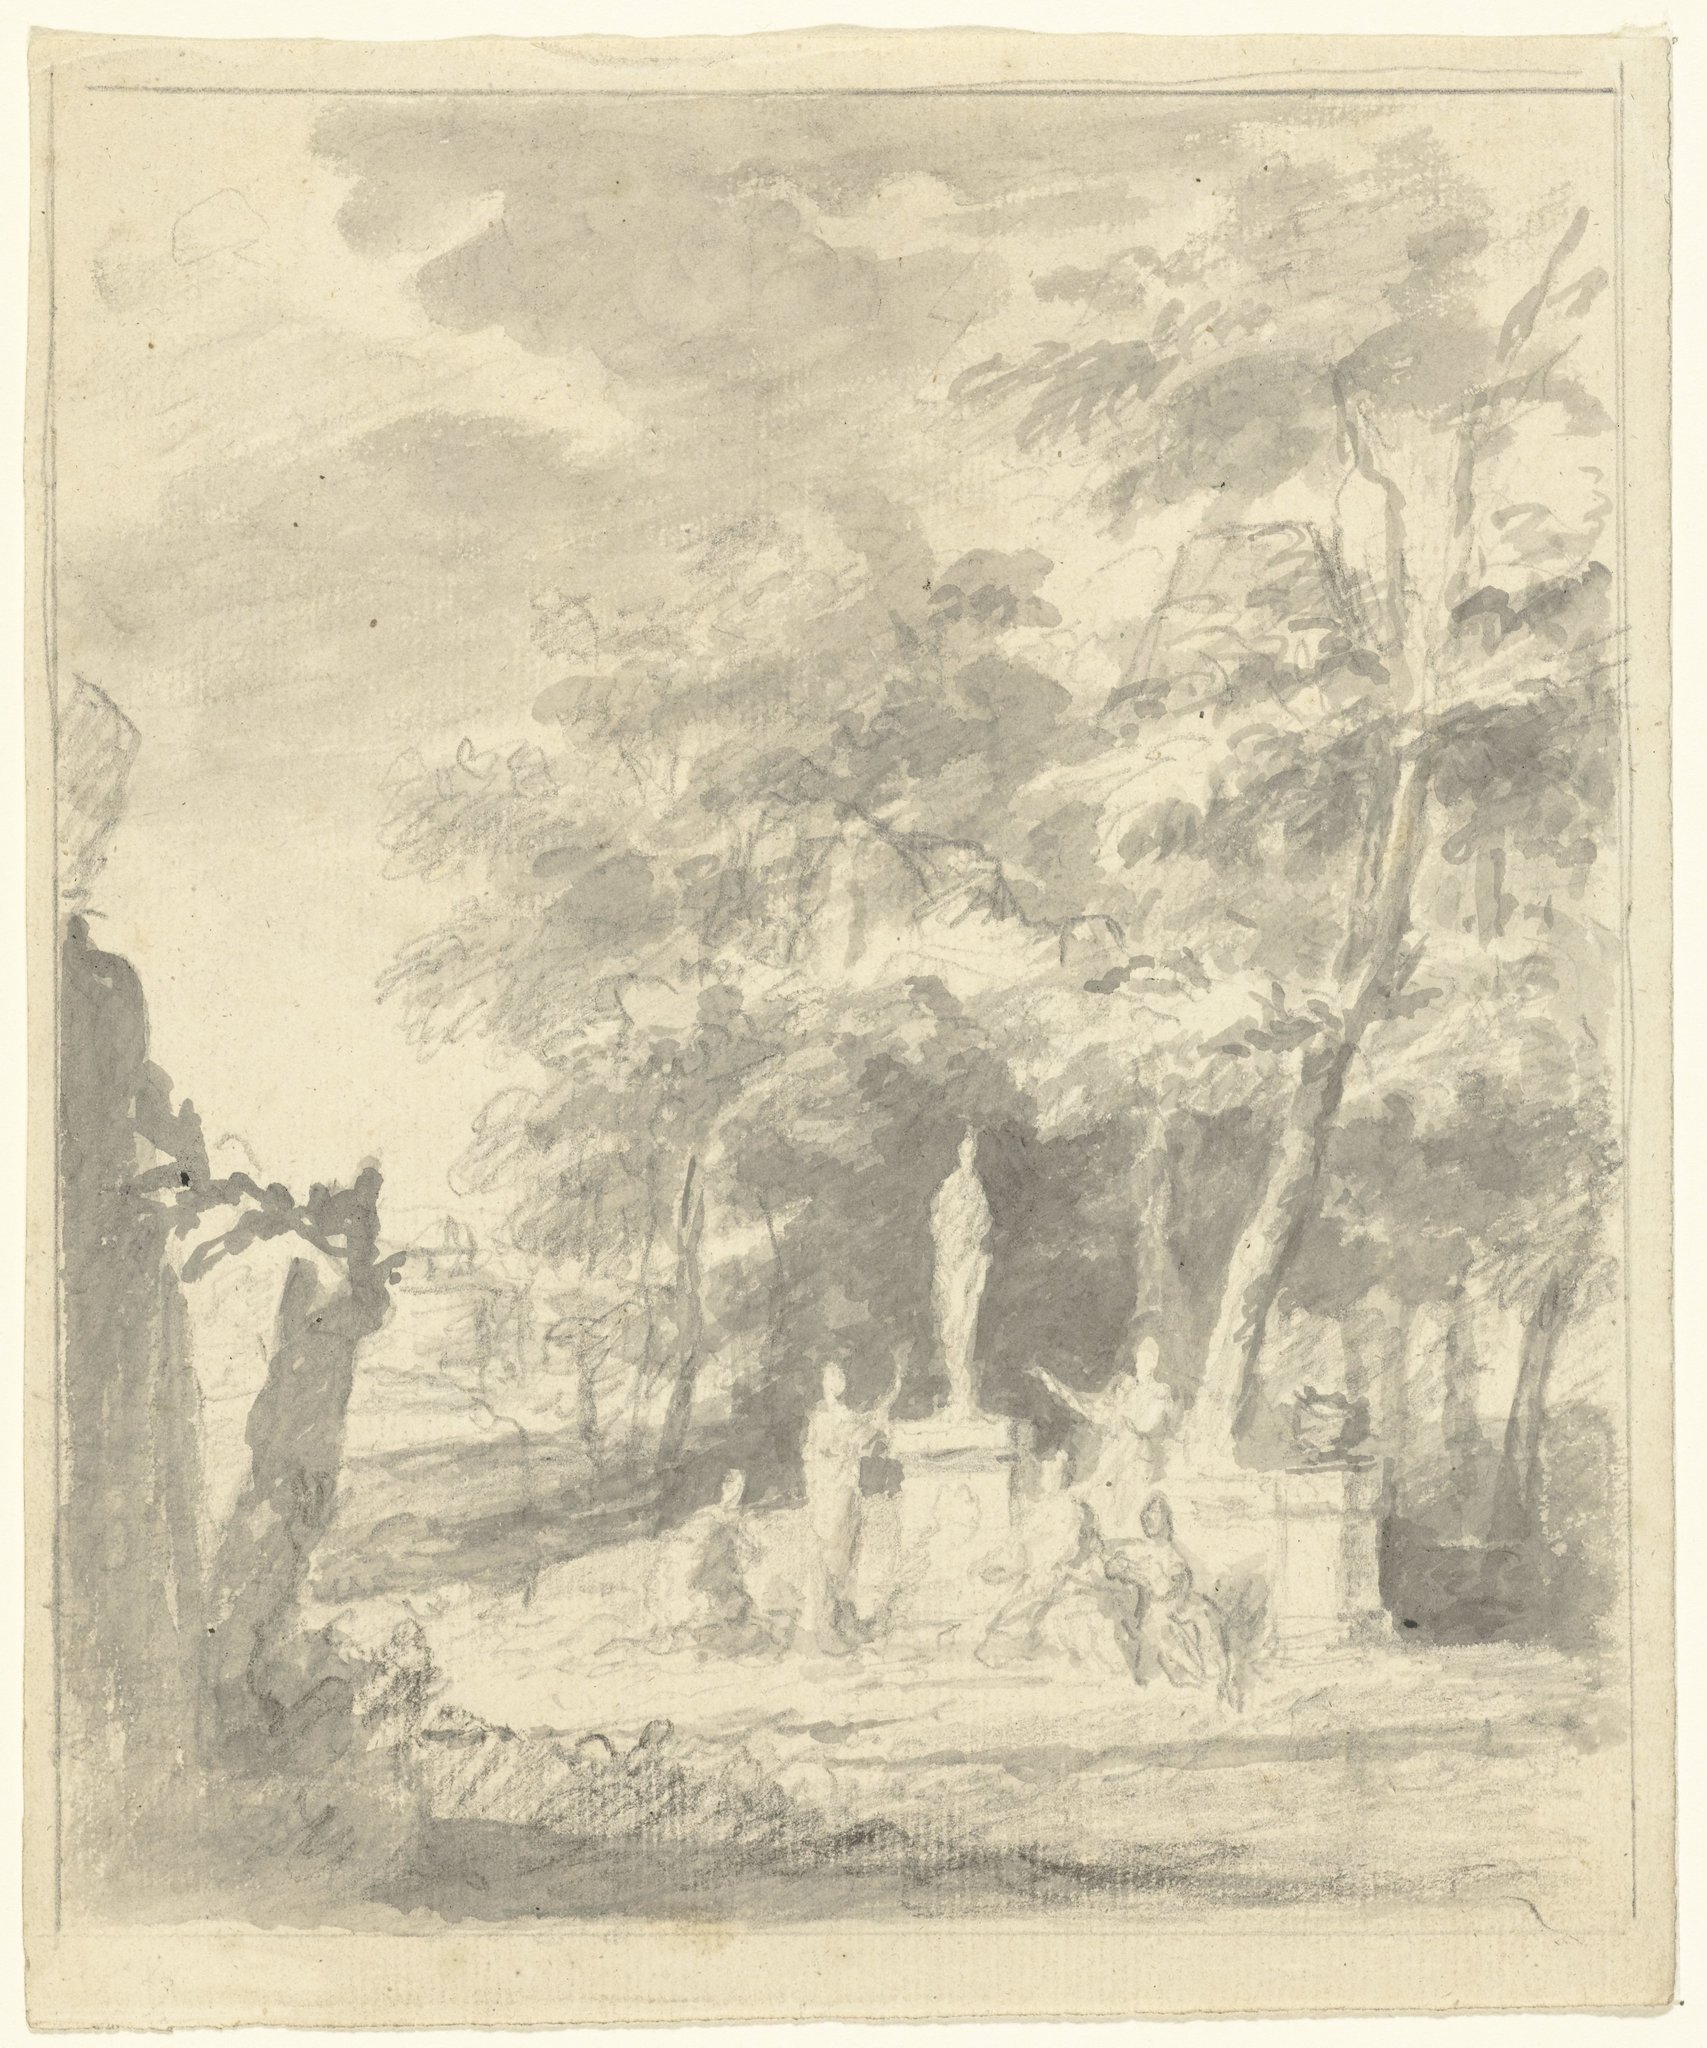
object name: design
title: Arcadisch landschap met figuren rond een standbeeld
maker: dionys van nijmegen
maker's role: draughtsman, painter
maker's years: 1705-1798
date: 1715-1798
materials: chalk, paper, pencil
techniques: brush